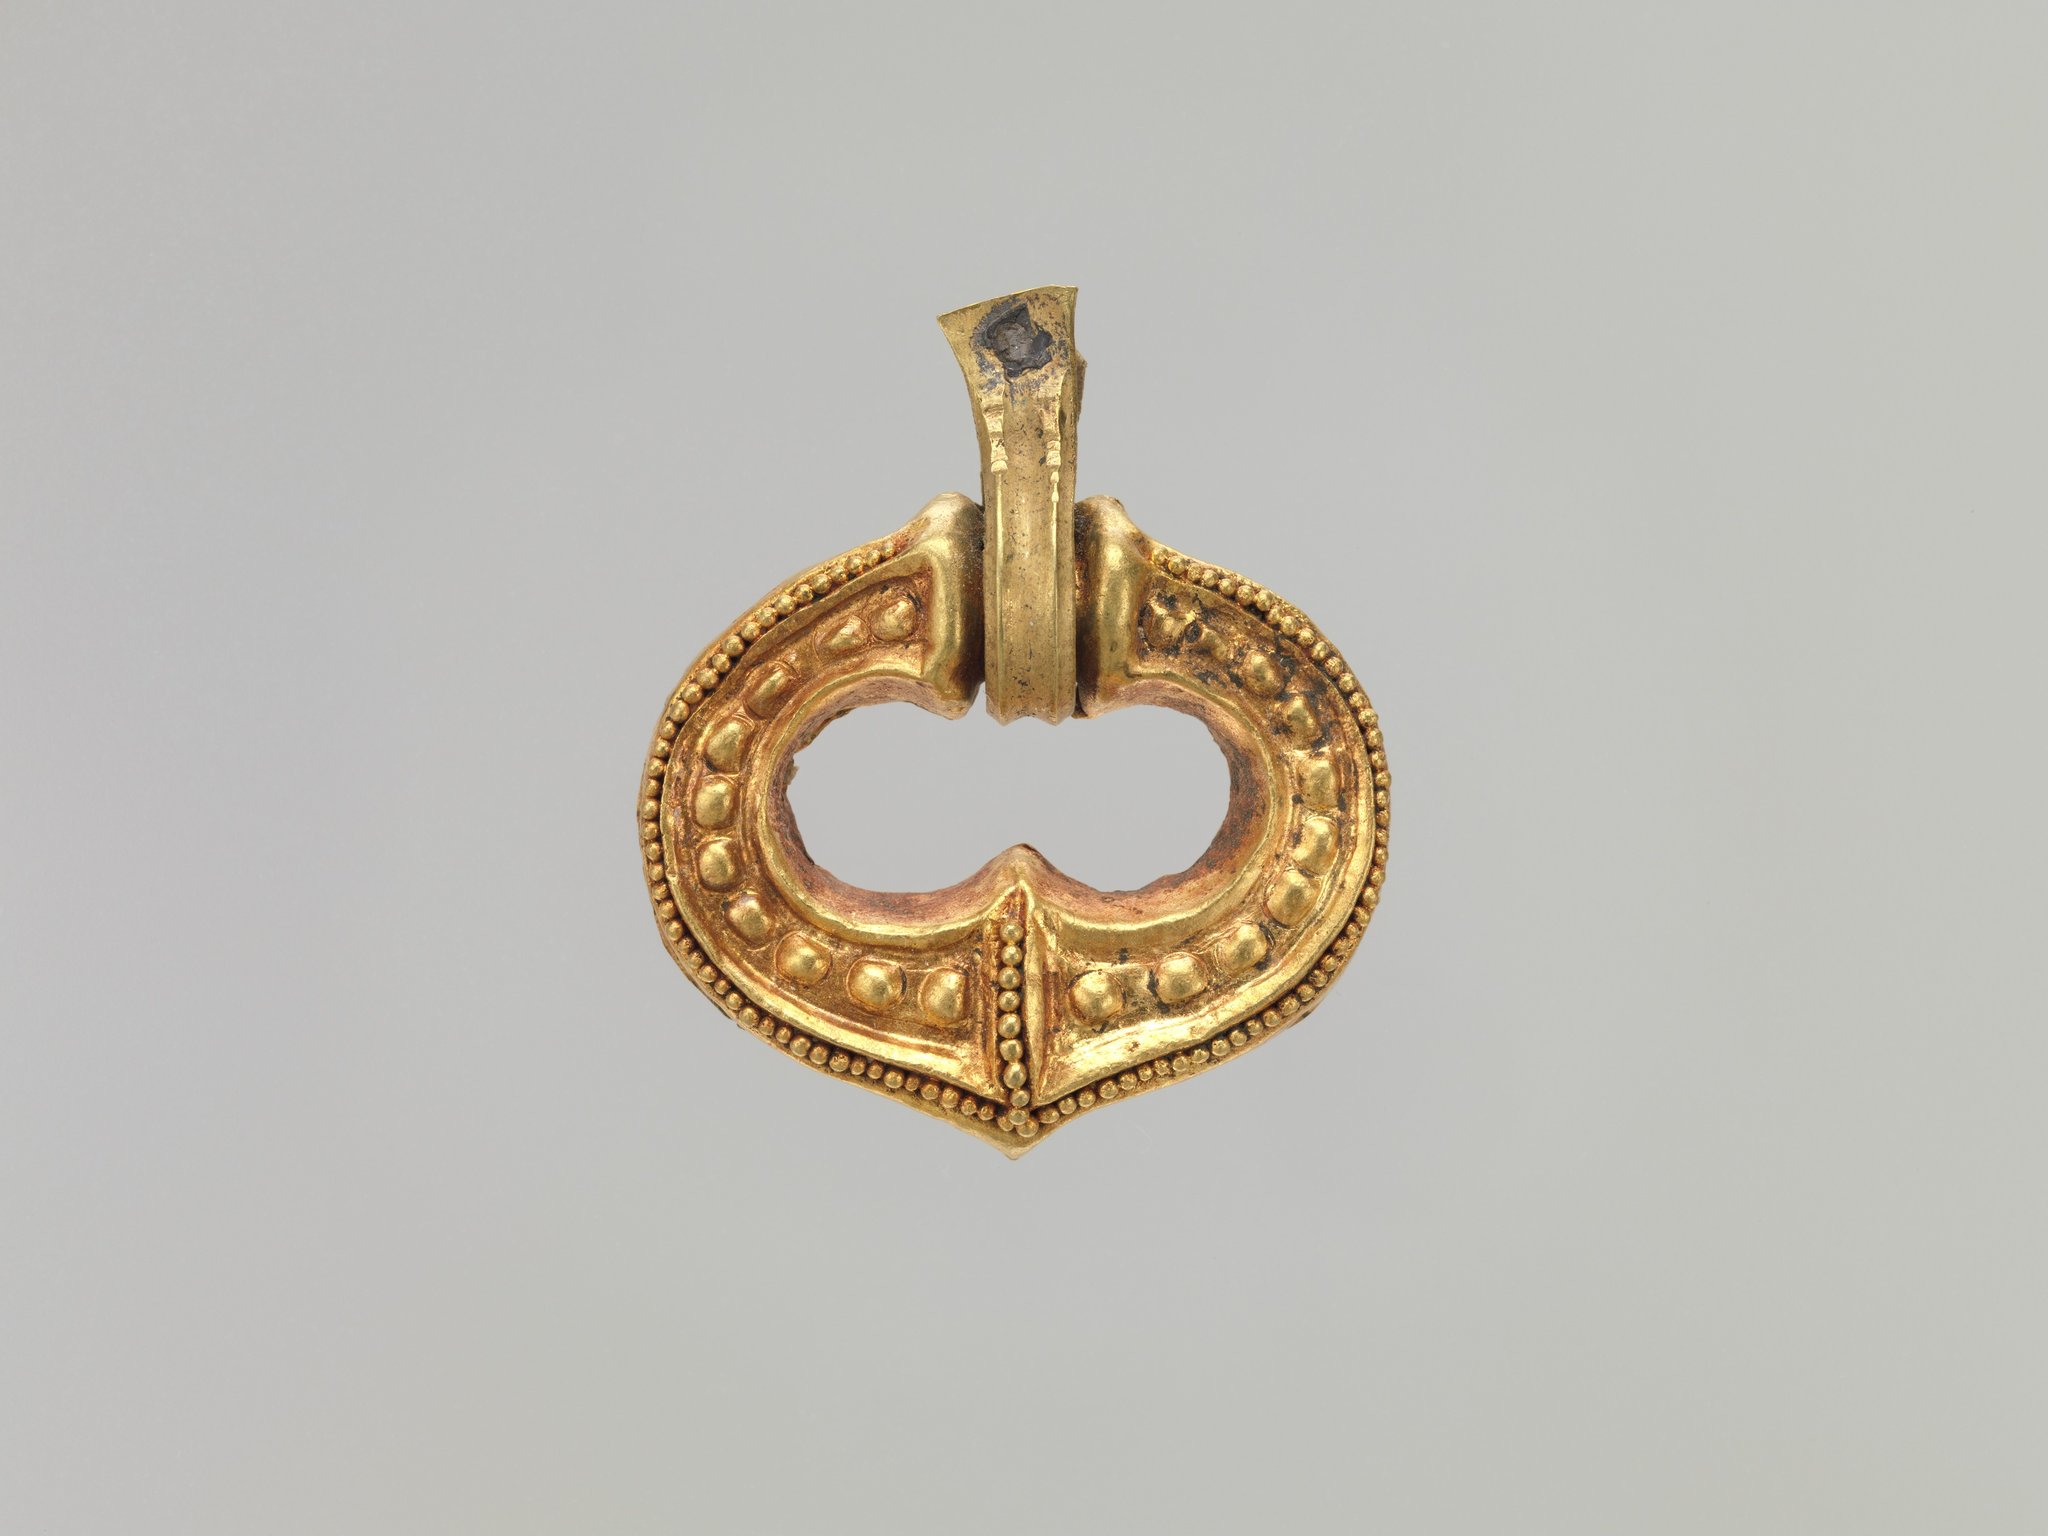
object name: suspension ring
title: Decorated Fitting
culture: chinese or central asian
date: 601-900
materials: gold